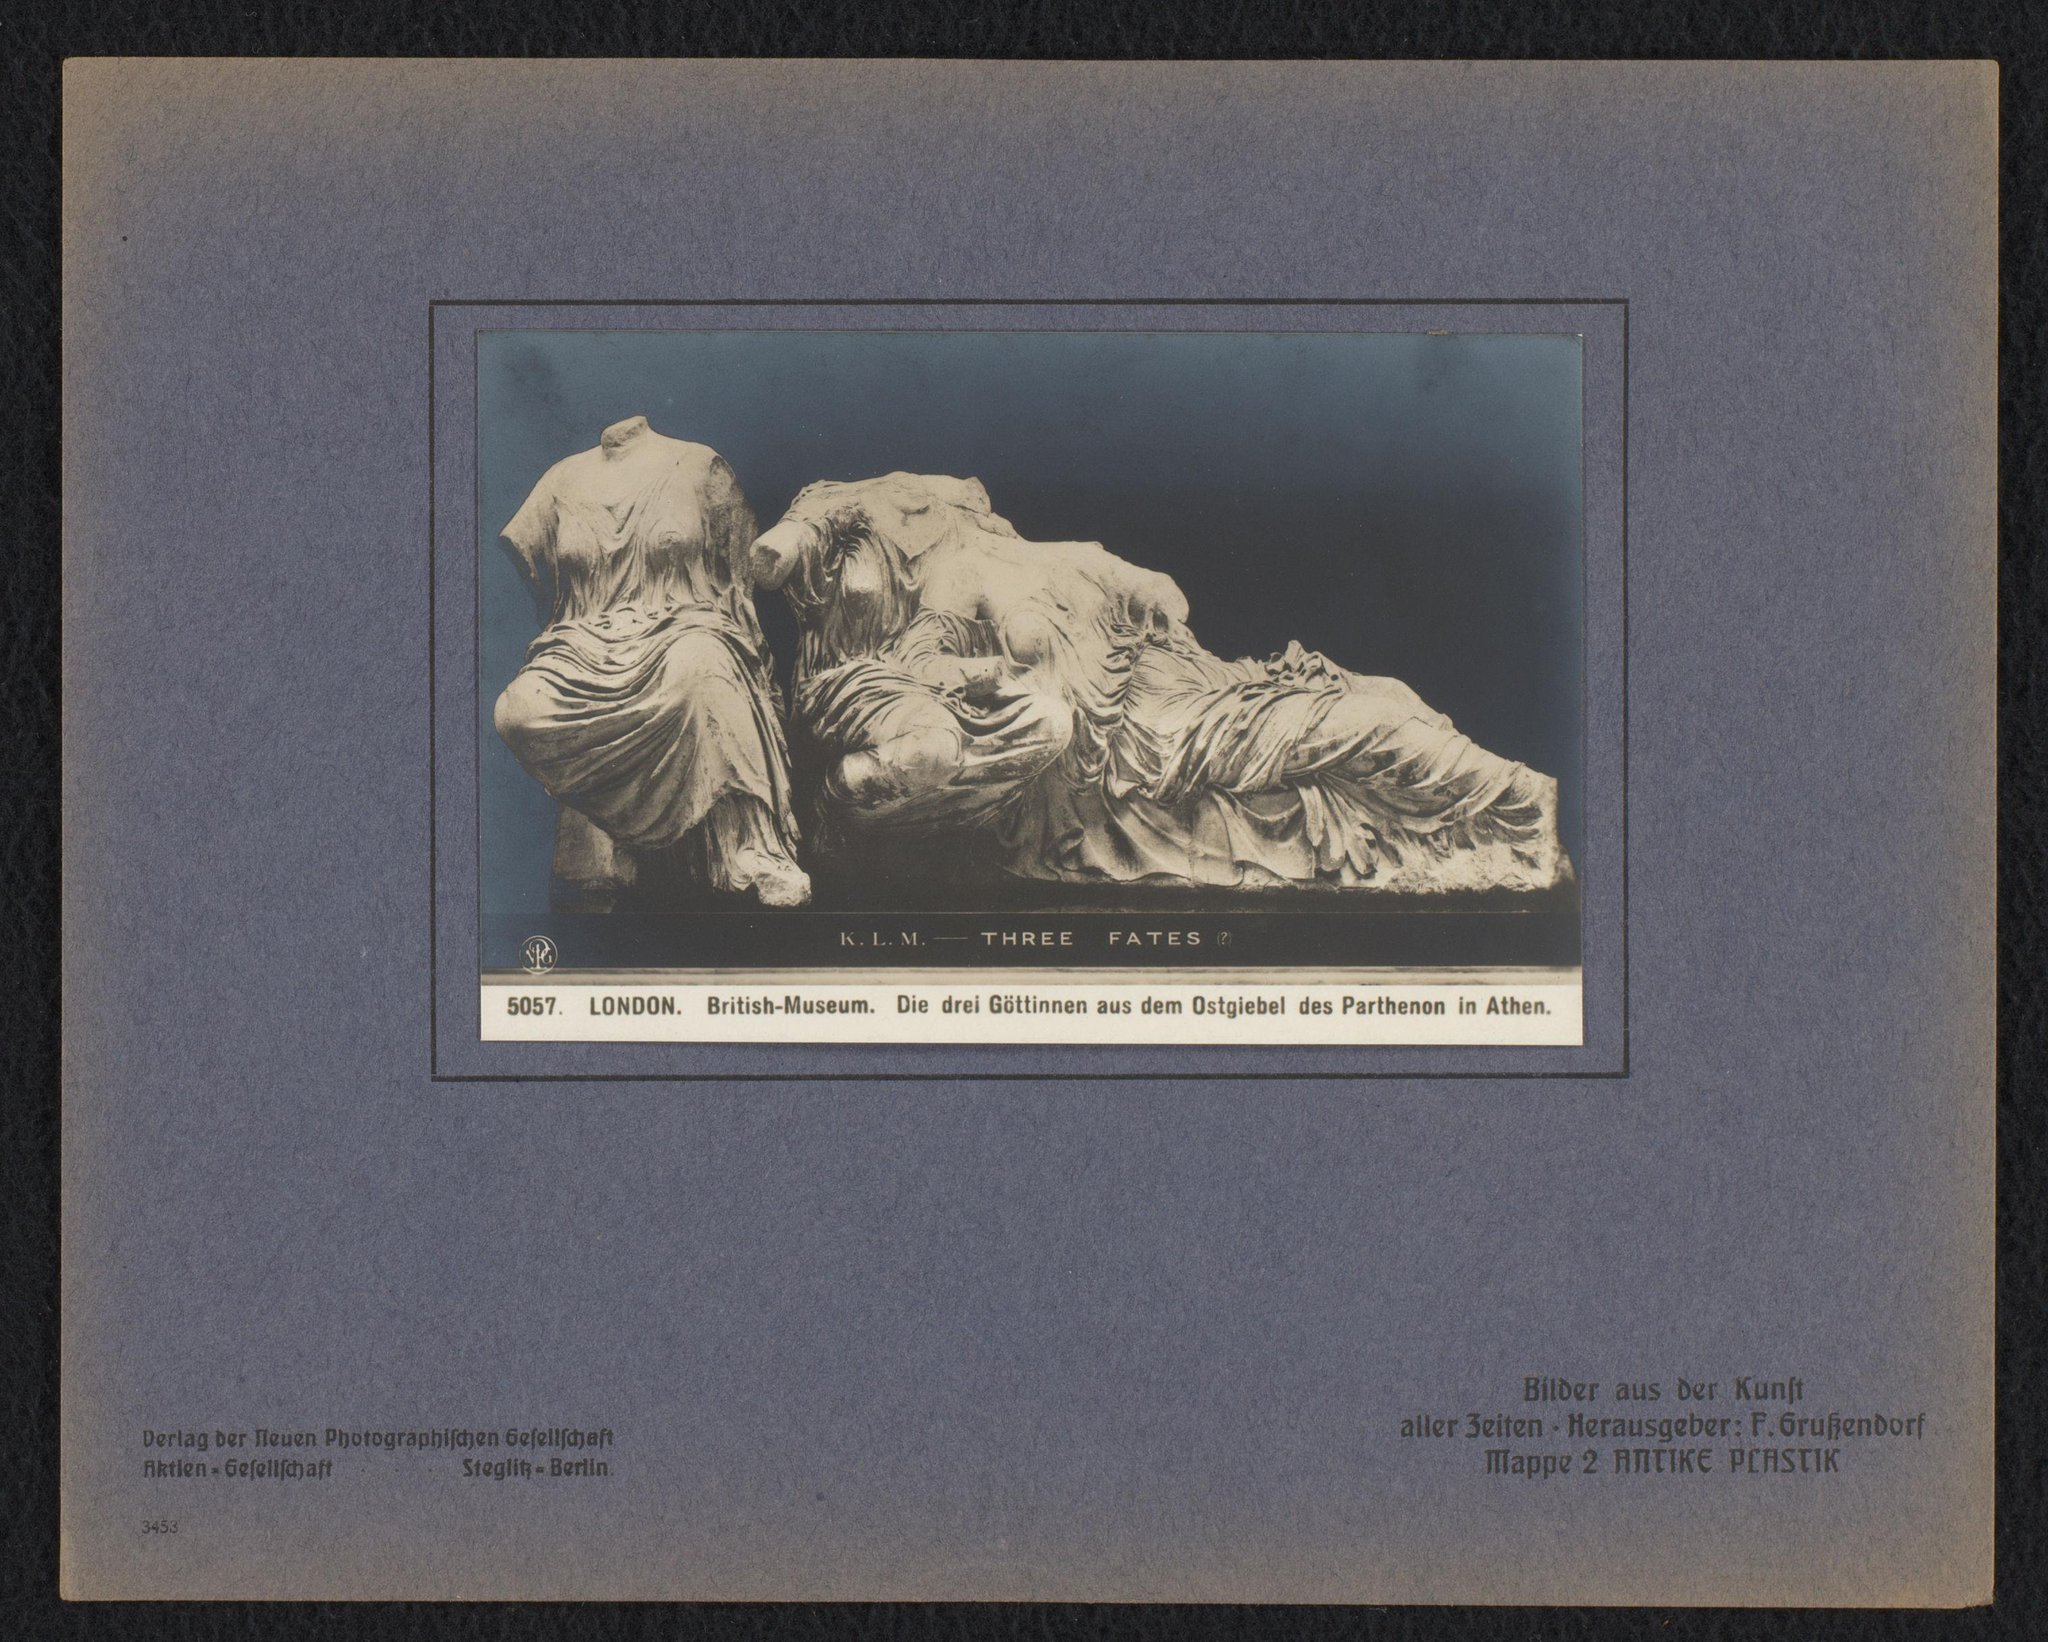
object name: photograph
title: Hestia, Dione en Aphrodite, uit het oostelijke fronton van het Parthenon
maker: Anonymous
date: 1906-1911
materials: paper, cardboard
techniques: gelatin silver print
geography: steglitz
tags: sculpture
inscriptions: number: ‘5057.’